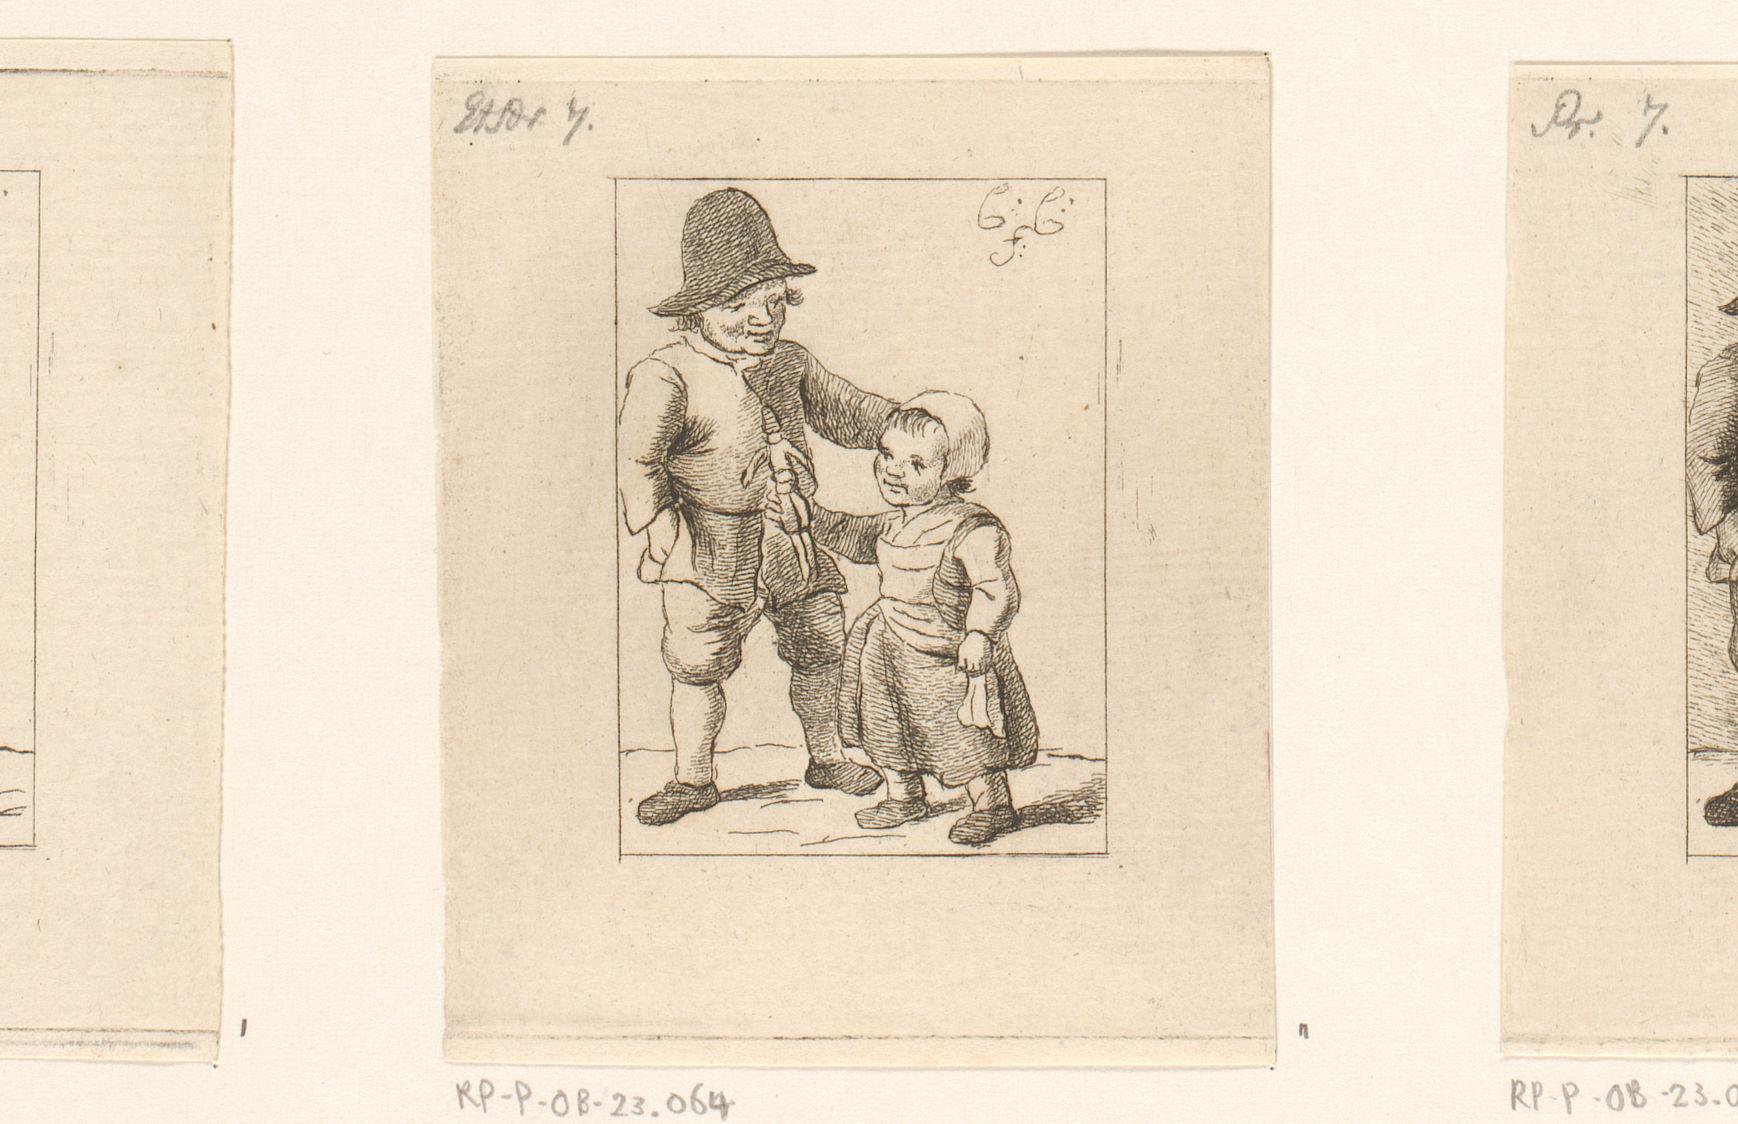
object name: print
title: Jongen en meisje met pop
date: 1779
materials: paper, pencil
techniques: etching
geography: leiden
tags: children's games and plays, (playing with) dolls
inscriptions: number: ‘Etsdr 7’, collector's mark: Lugt 240